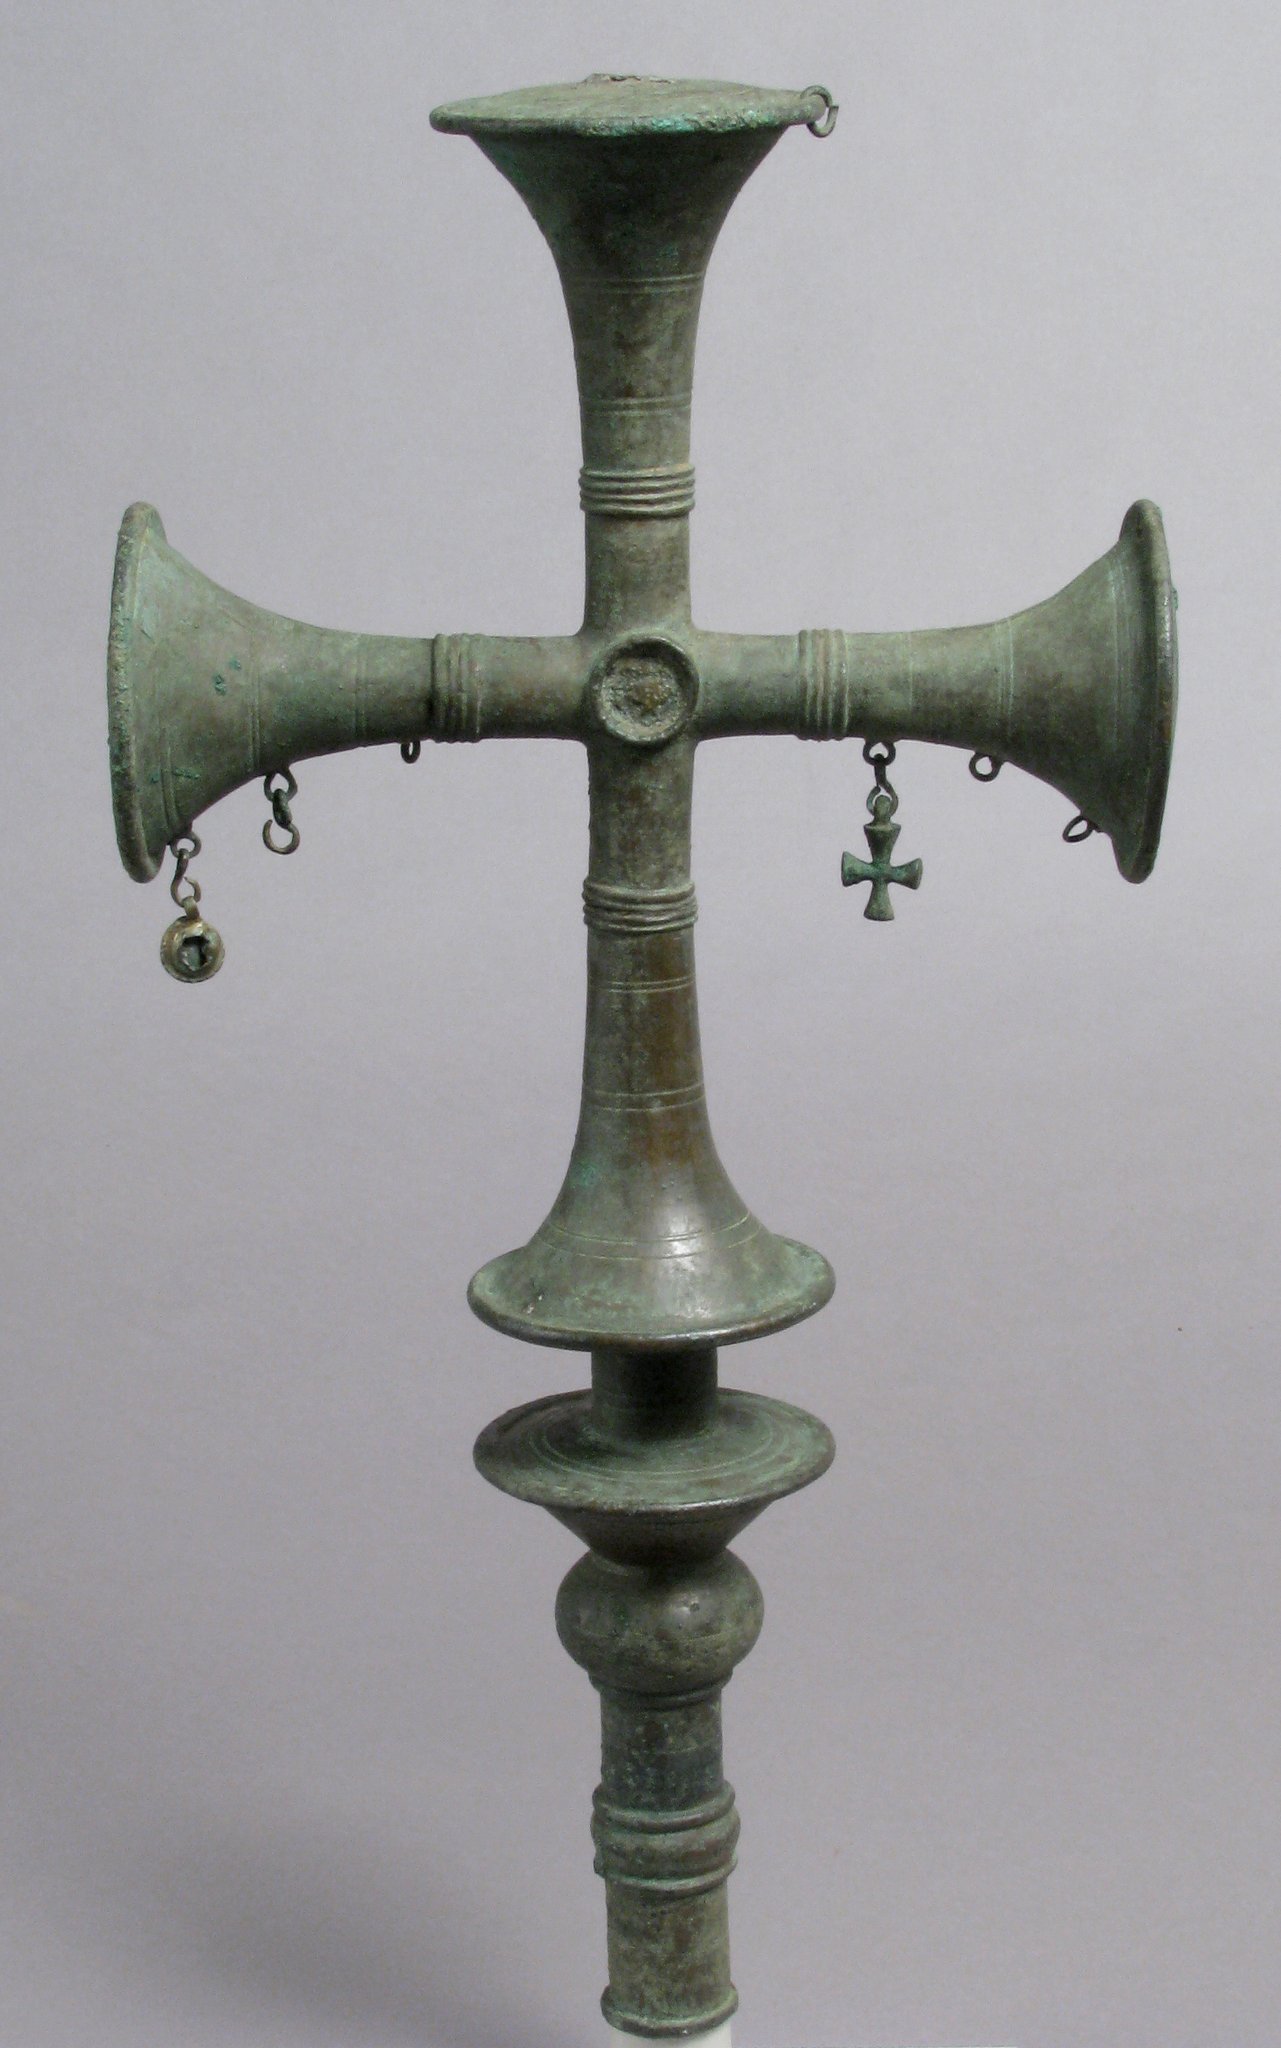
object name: cross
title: Processional Cross with Hanging Ornaments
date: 500-599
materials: bronze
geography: egypt